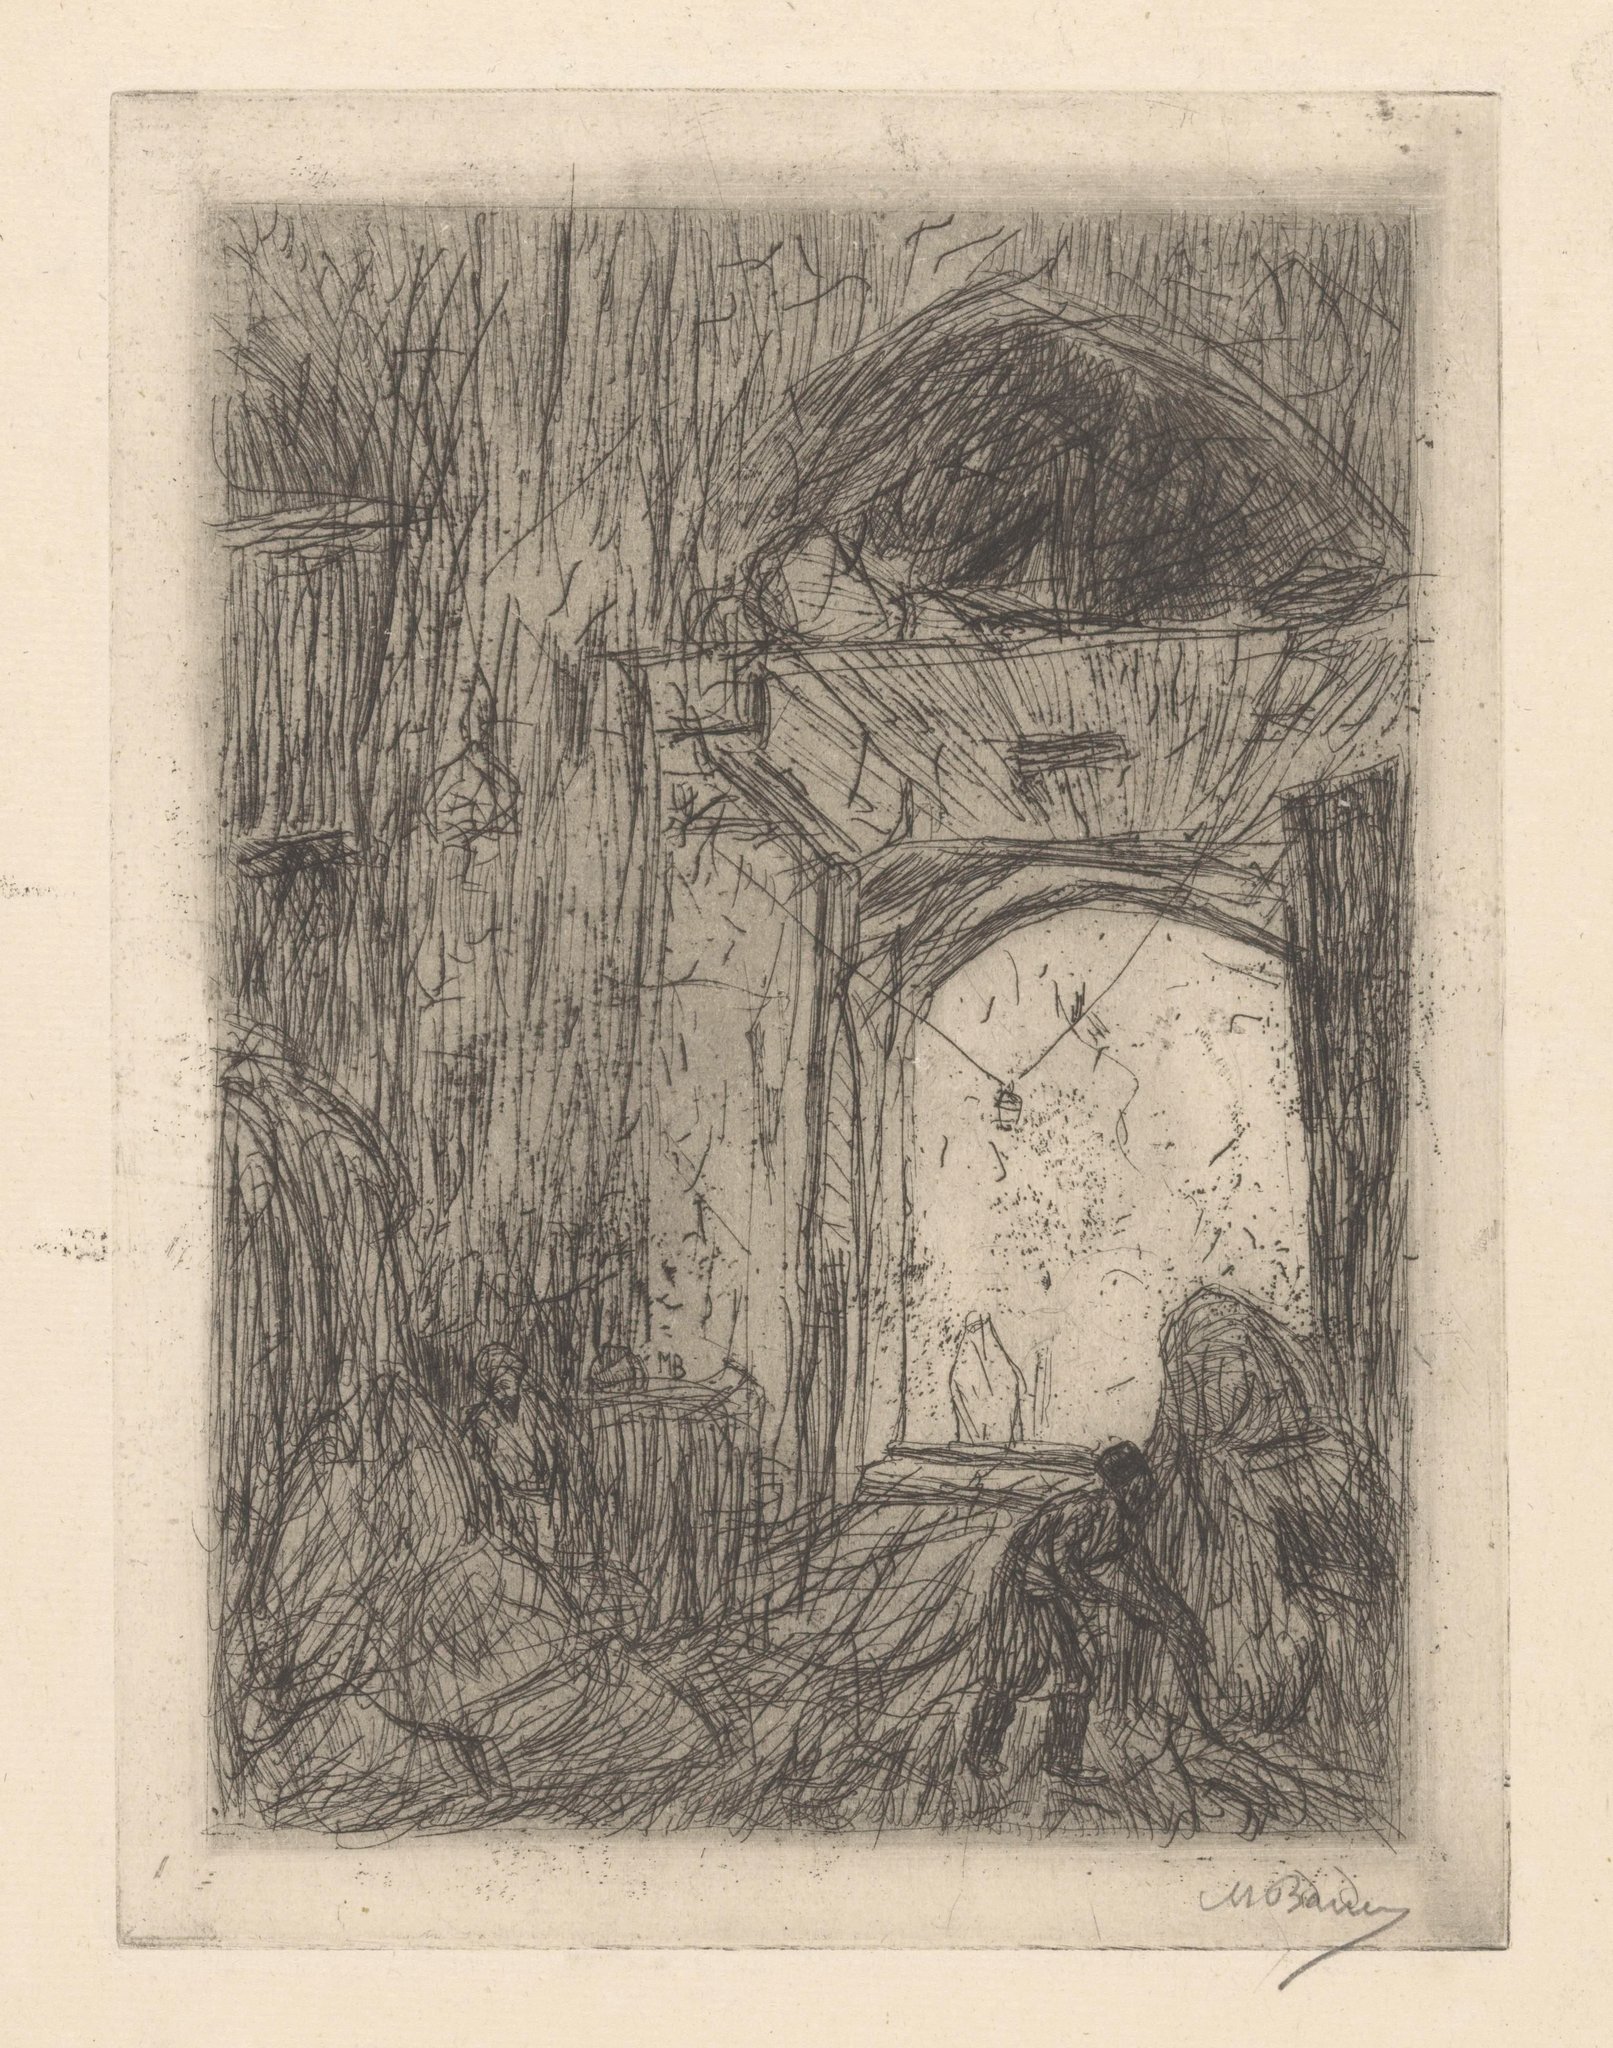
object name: print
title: Ingang van een bazaar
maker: marius bauer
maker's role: draughtsman, print maker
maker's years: 1867-1932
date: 1890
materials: paper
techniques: etching, intaglio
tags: gate, entrance, market-hall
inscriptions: collector's mark: Lugt 2228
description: Toegangspoort met lantaarn aan een touw van een bazaar. Op de voorgrond enkele figuren in oosterse kleding.